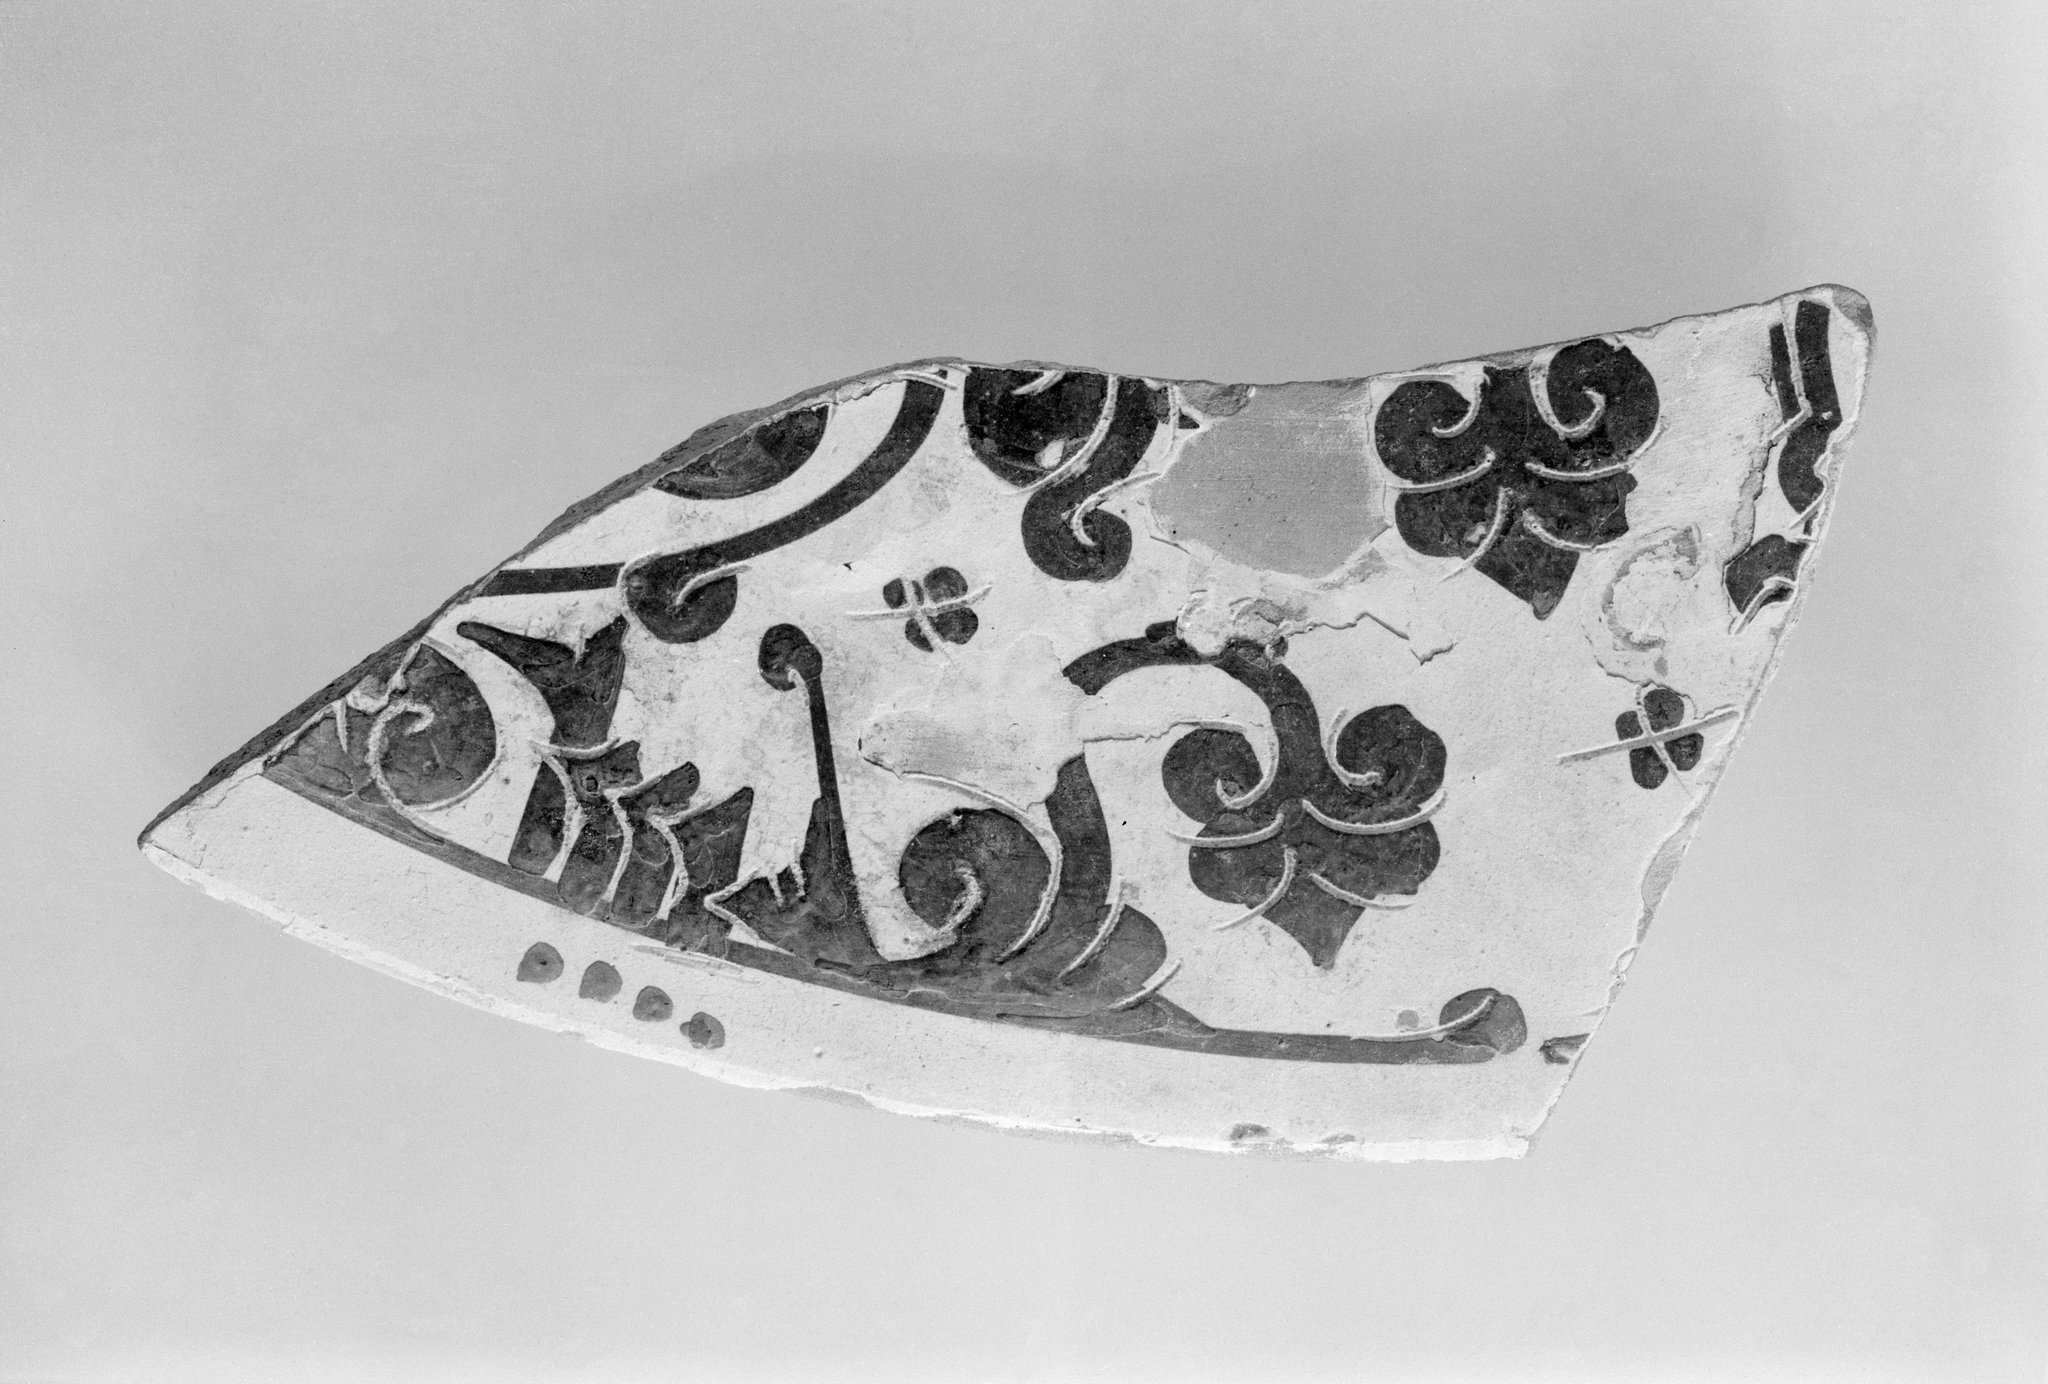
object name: fragment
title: Fragment of a Plate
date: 901-1000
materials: earthenware, glaze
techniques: incising, polychrome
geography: iran